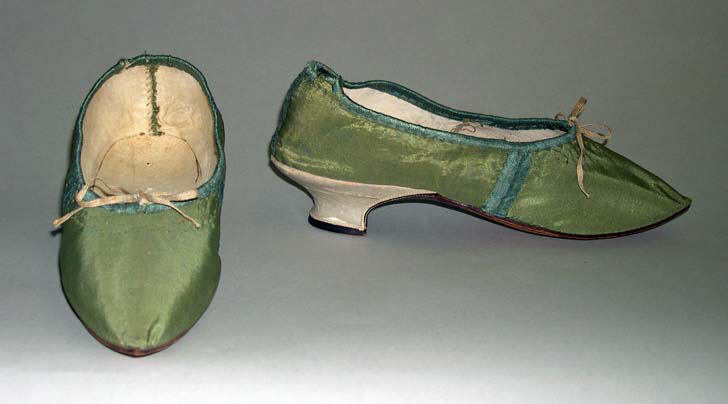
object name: shoe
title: Shoes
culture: european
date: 1770-1789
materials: leather, linen, silk